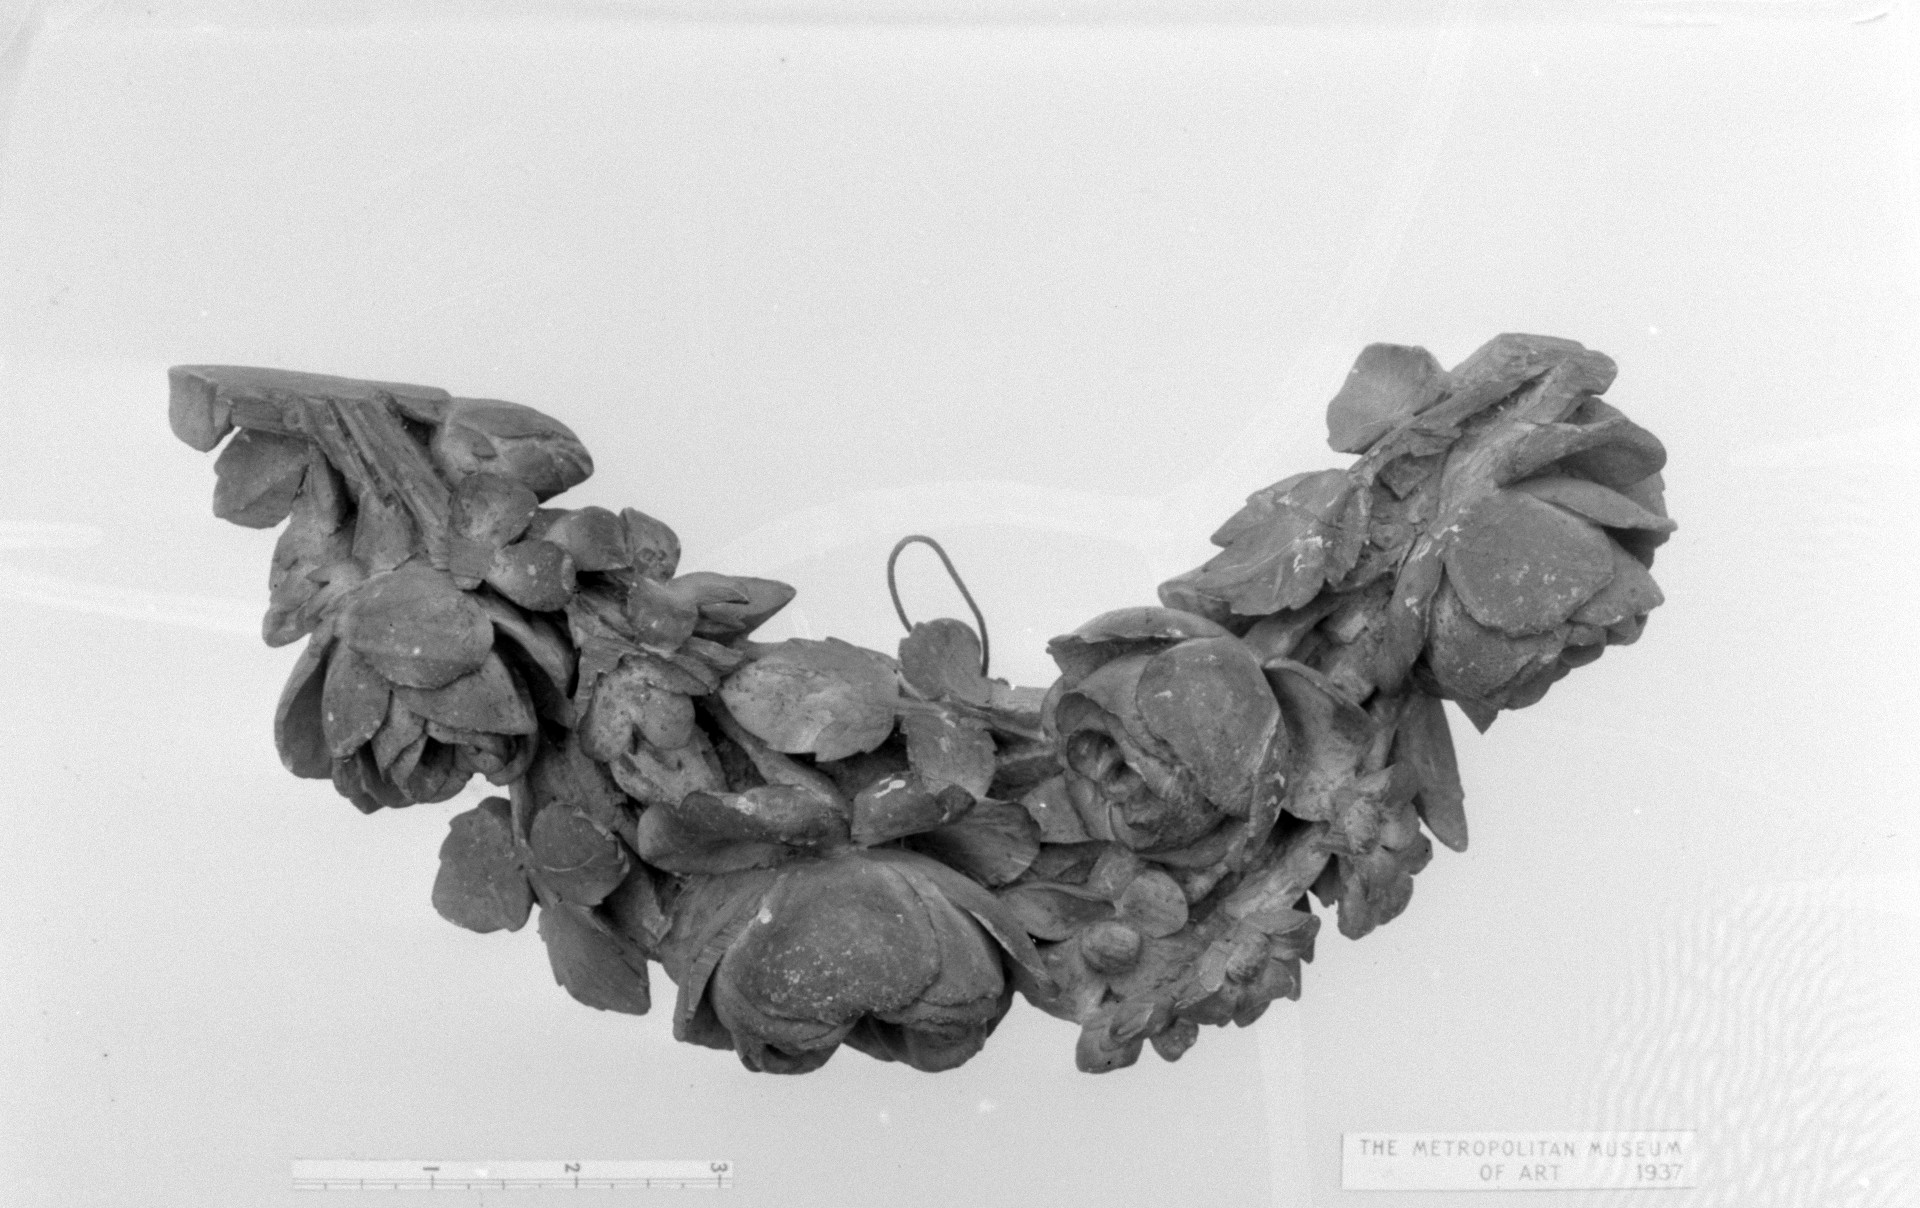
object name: garland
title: Garland (part of a set)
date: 1701-1800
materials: gilt, wood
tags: garlands,flowers